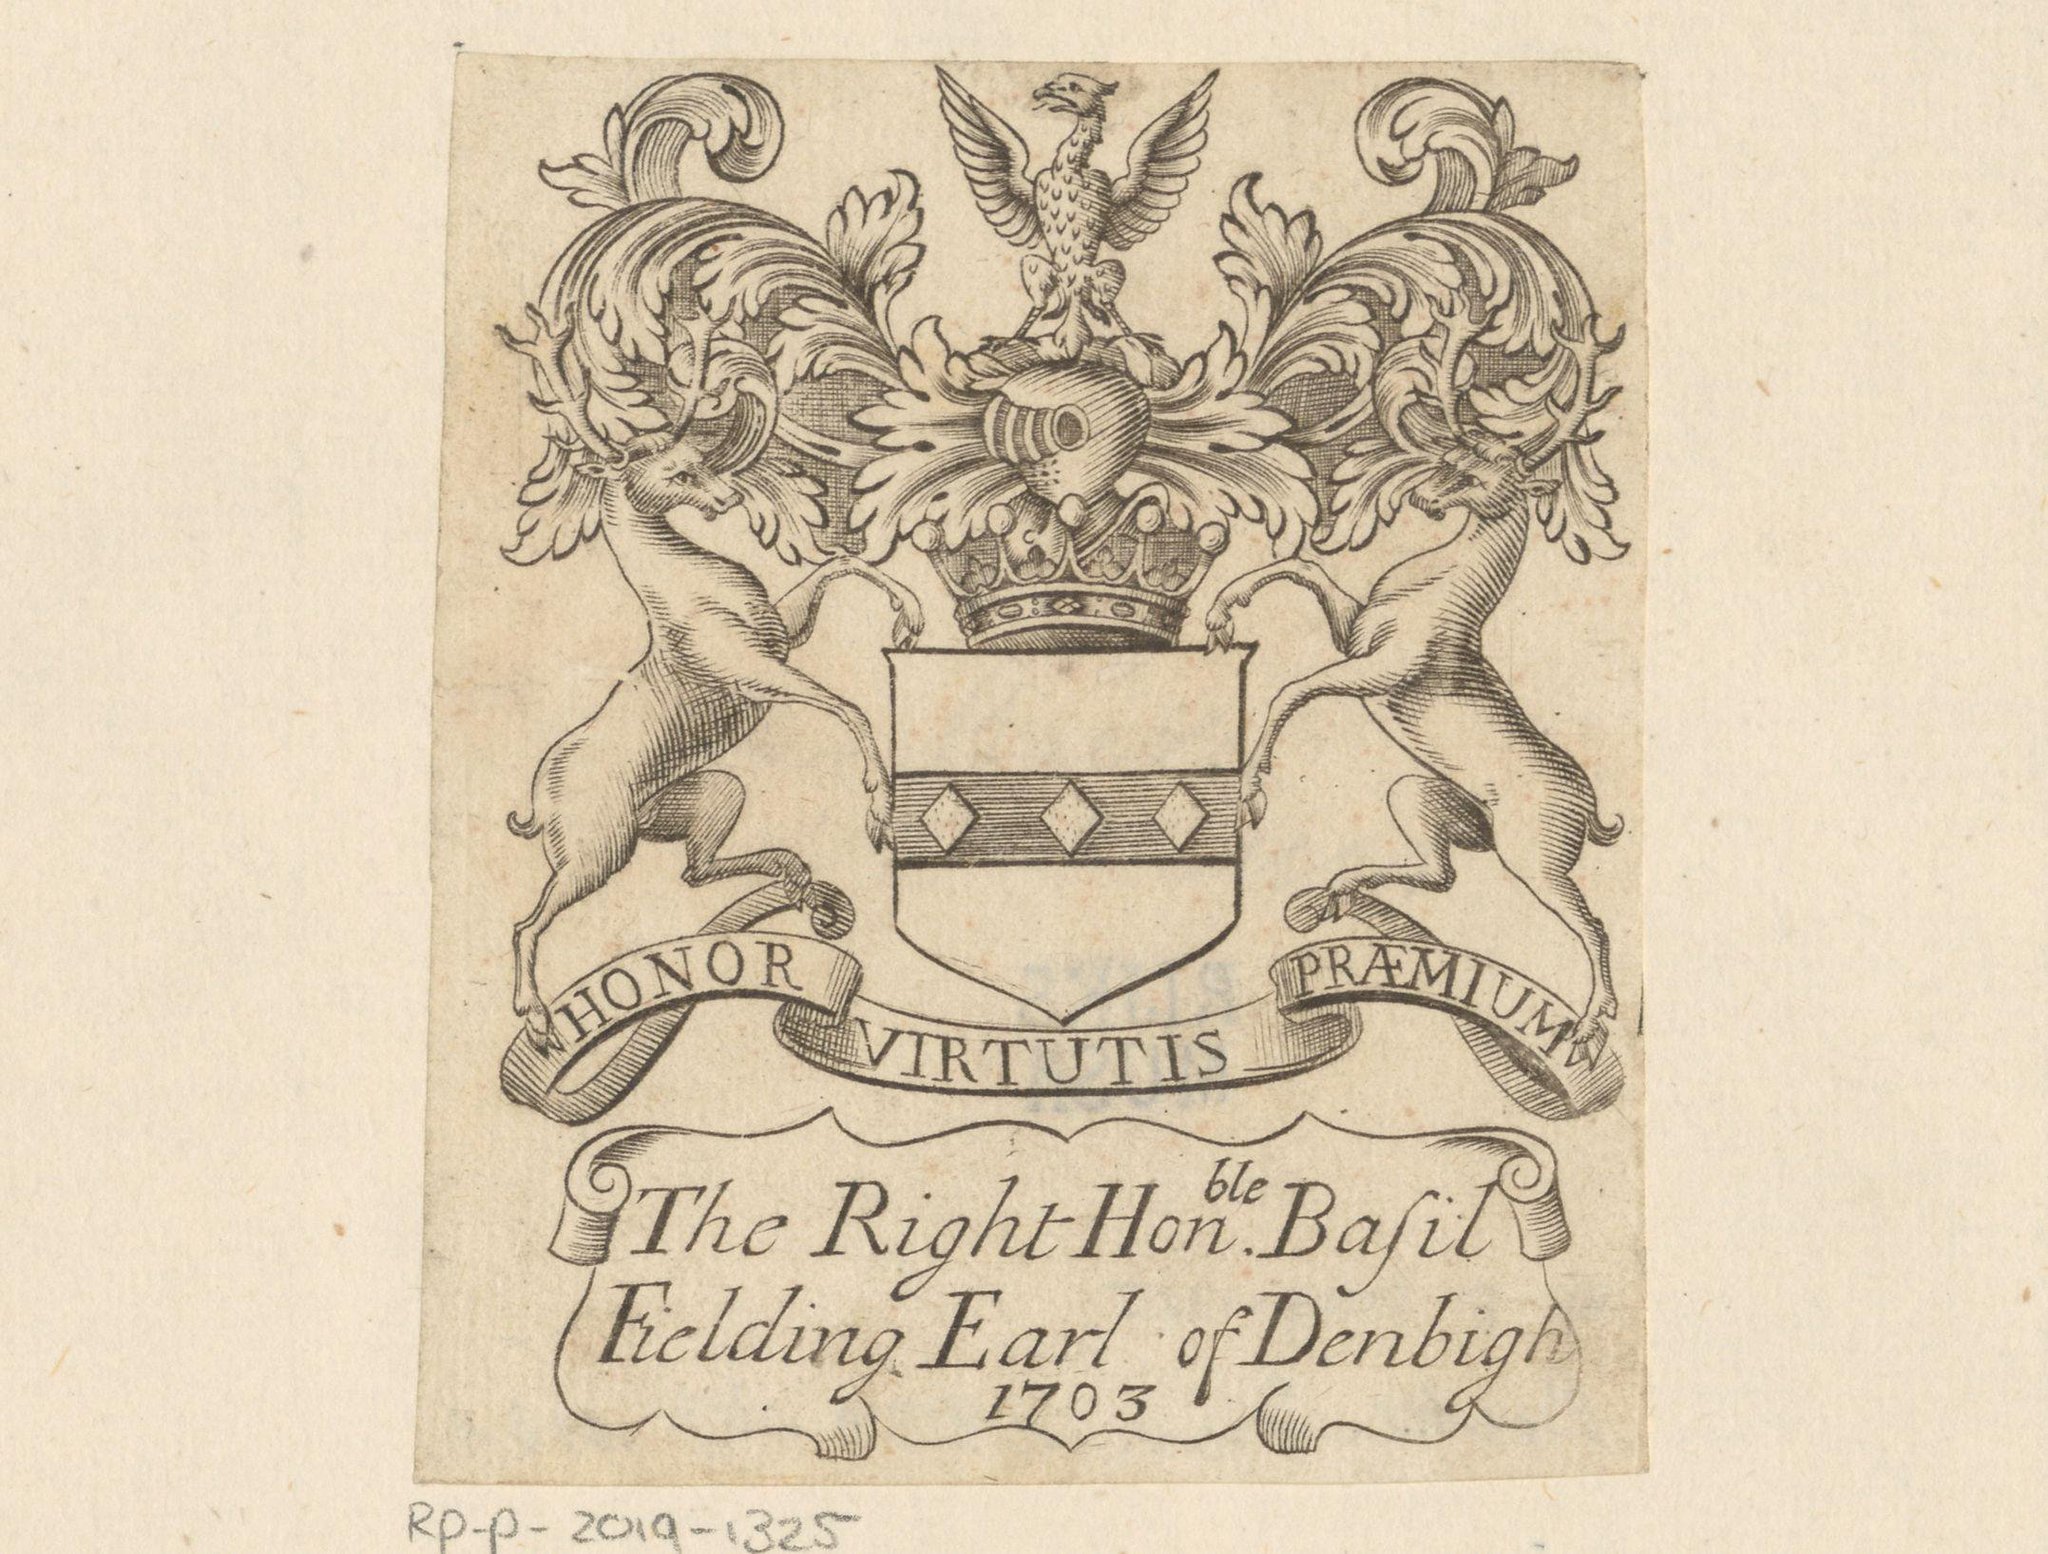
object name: bookplate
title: Honor virtutis praemium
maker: Anonymous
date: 1703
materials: paper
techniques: engraving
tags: england, armorial bearing, heraldry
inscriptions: collector's mark: Lugt 2166